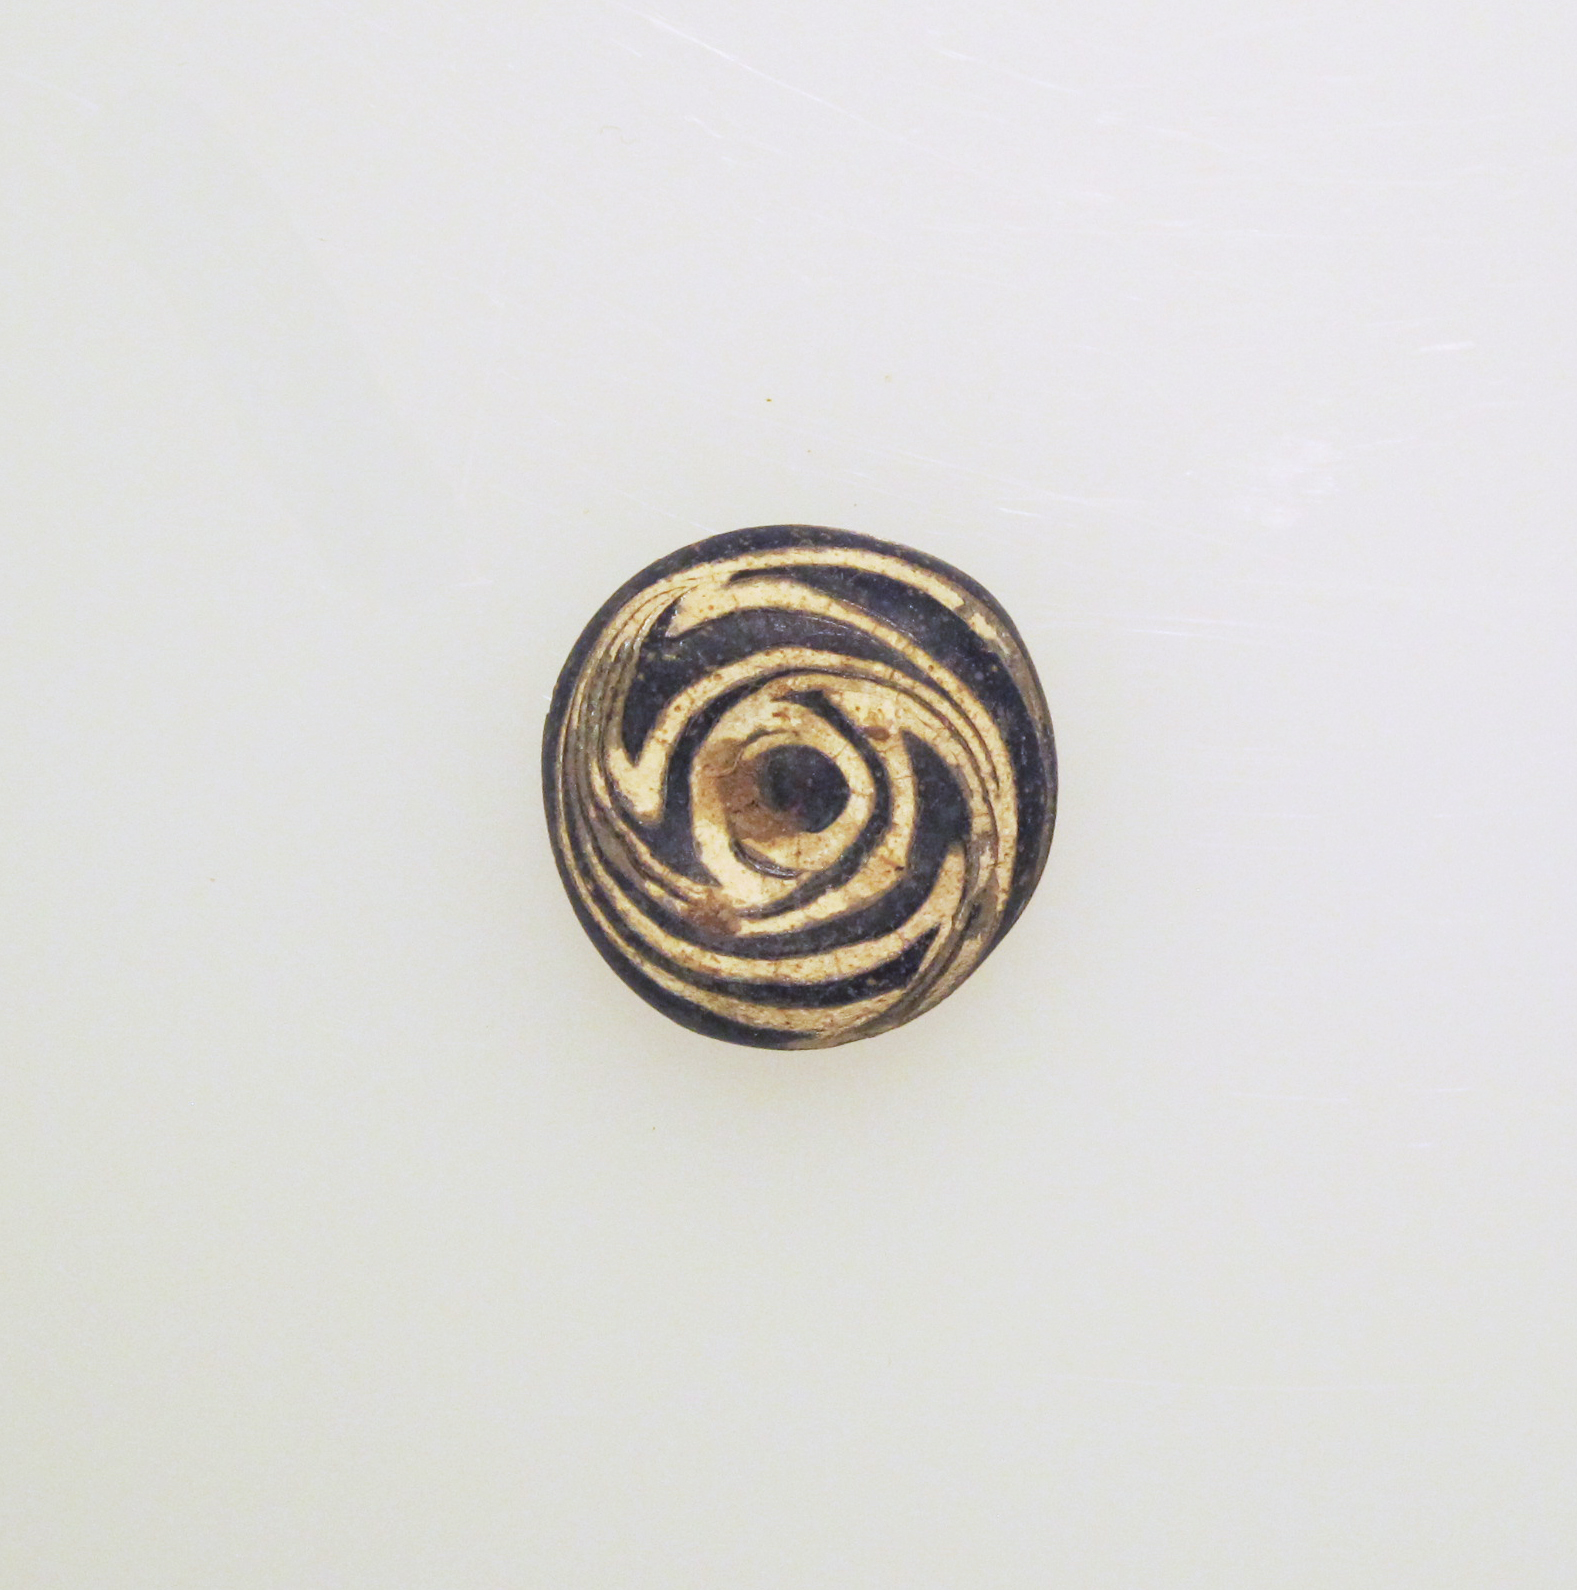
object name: pinhead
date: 7000 BCE-330 CE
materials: glass